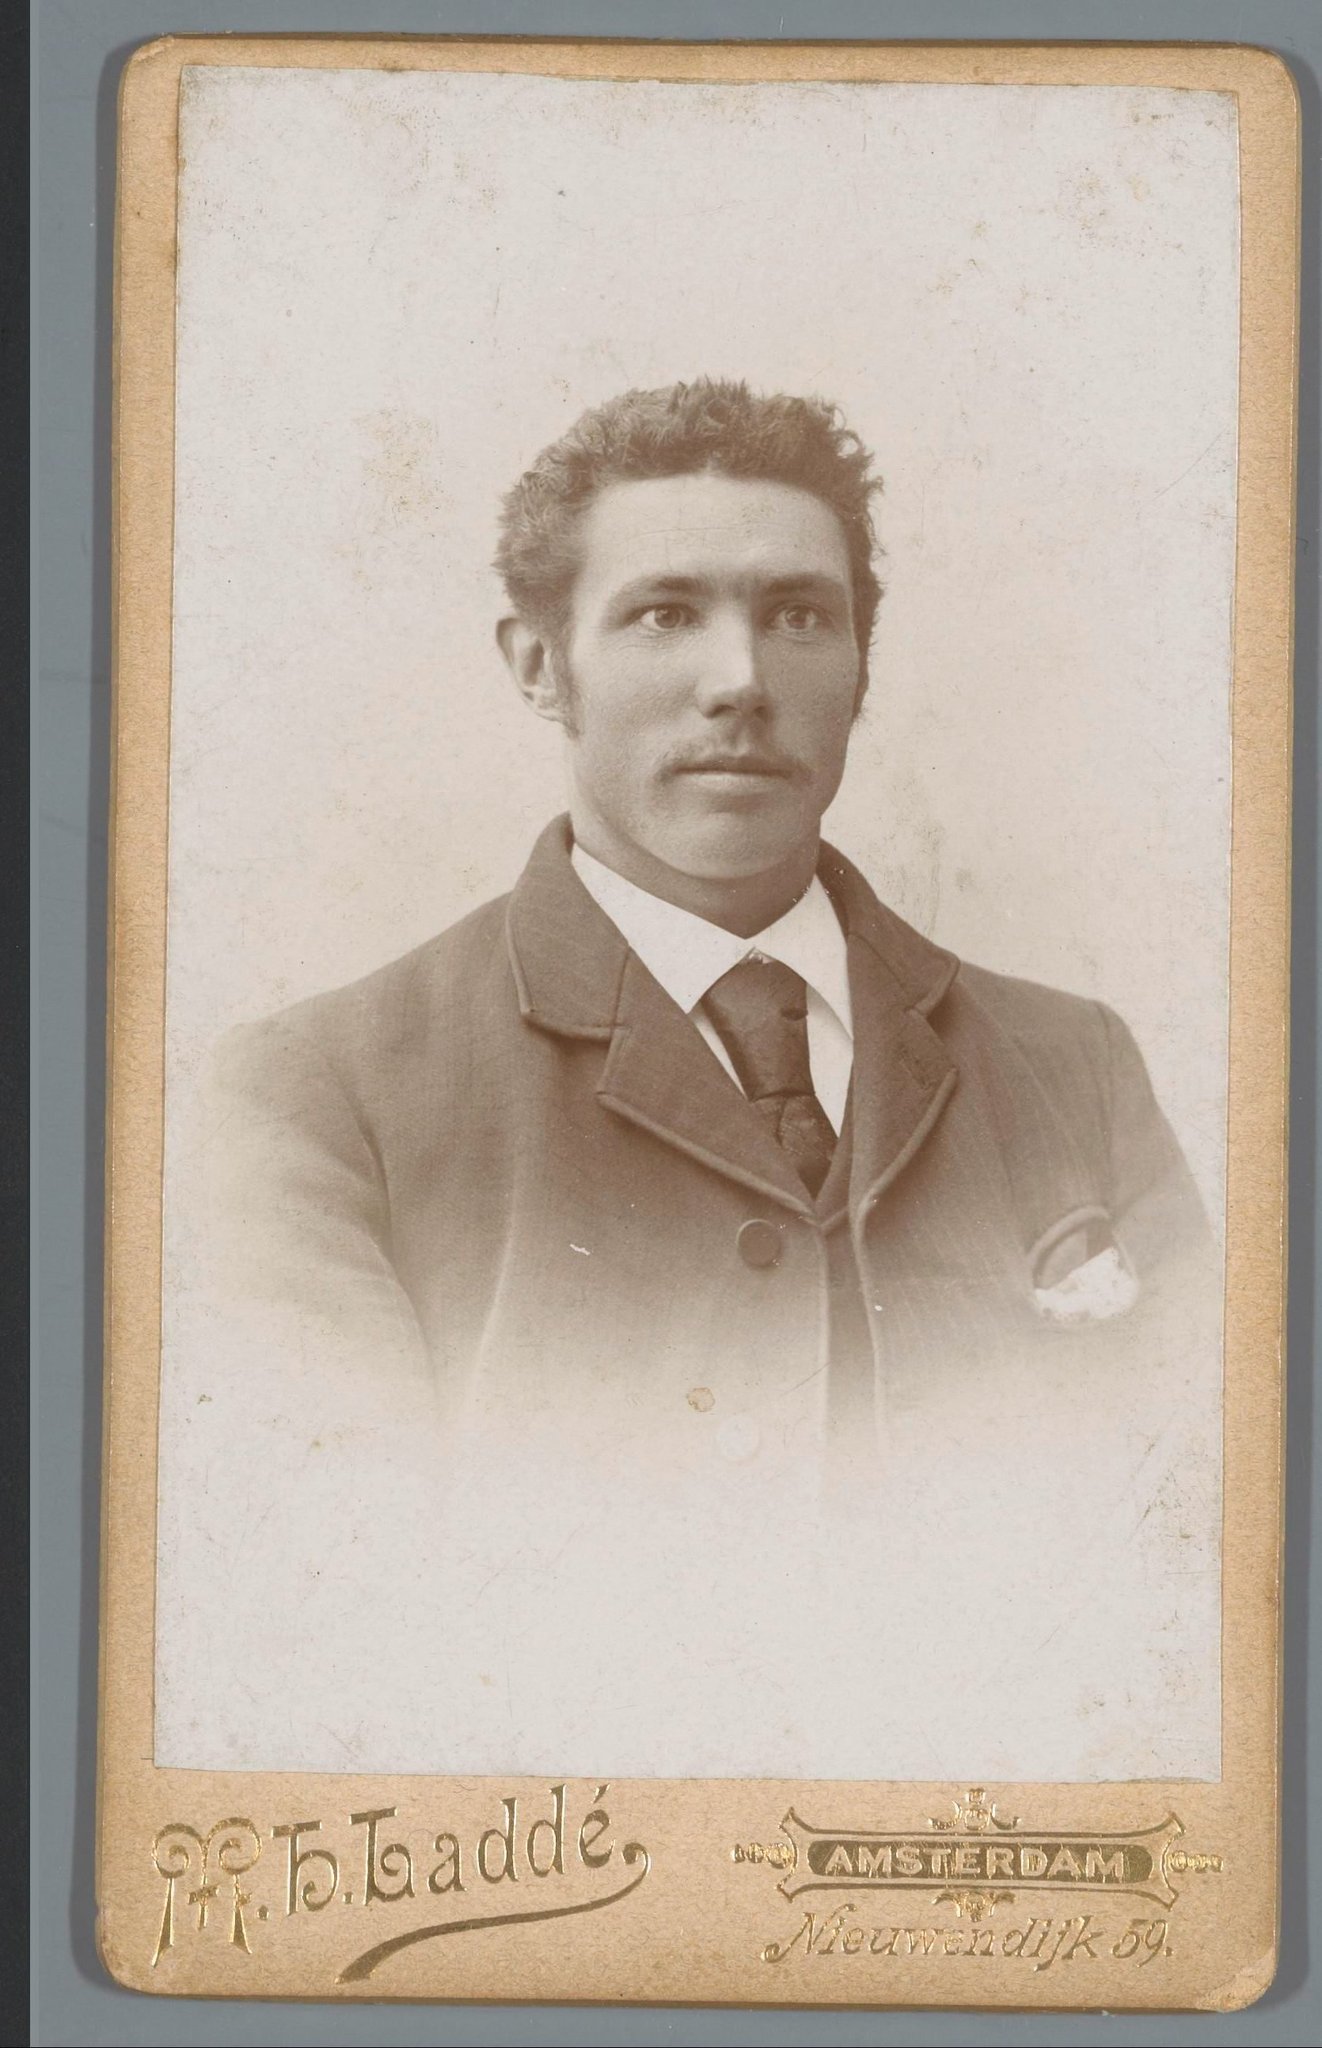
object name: carte de visite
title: Portret van een onbekende man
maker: machiel hendricus laddé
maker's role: fotograaf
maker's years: 1866-1932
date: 1892-1906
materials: cardboard, photographic support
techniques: collodion silver print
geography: amsterdam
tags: adult man, historical persons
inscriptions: inscription: ‘PHOTOGRAPHIE/ ARTISTIQUE/ M. H. LADDÉ/ Nieuwendijk 59/ boven de Firma/ MERKELBACH & Co/ AMSTERDAM/ Het Cliché wordt voor verdere bestellingen bewaard.’